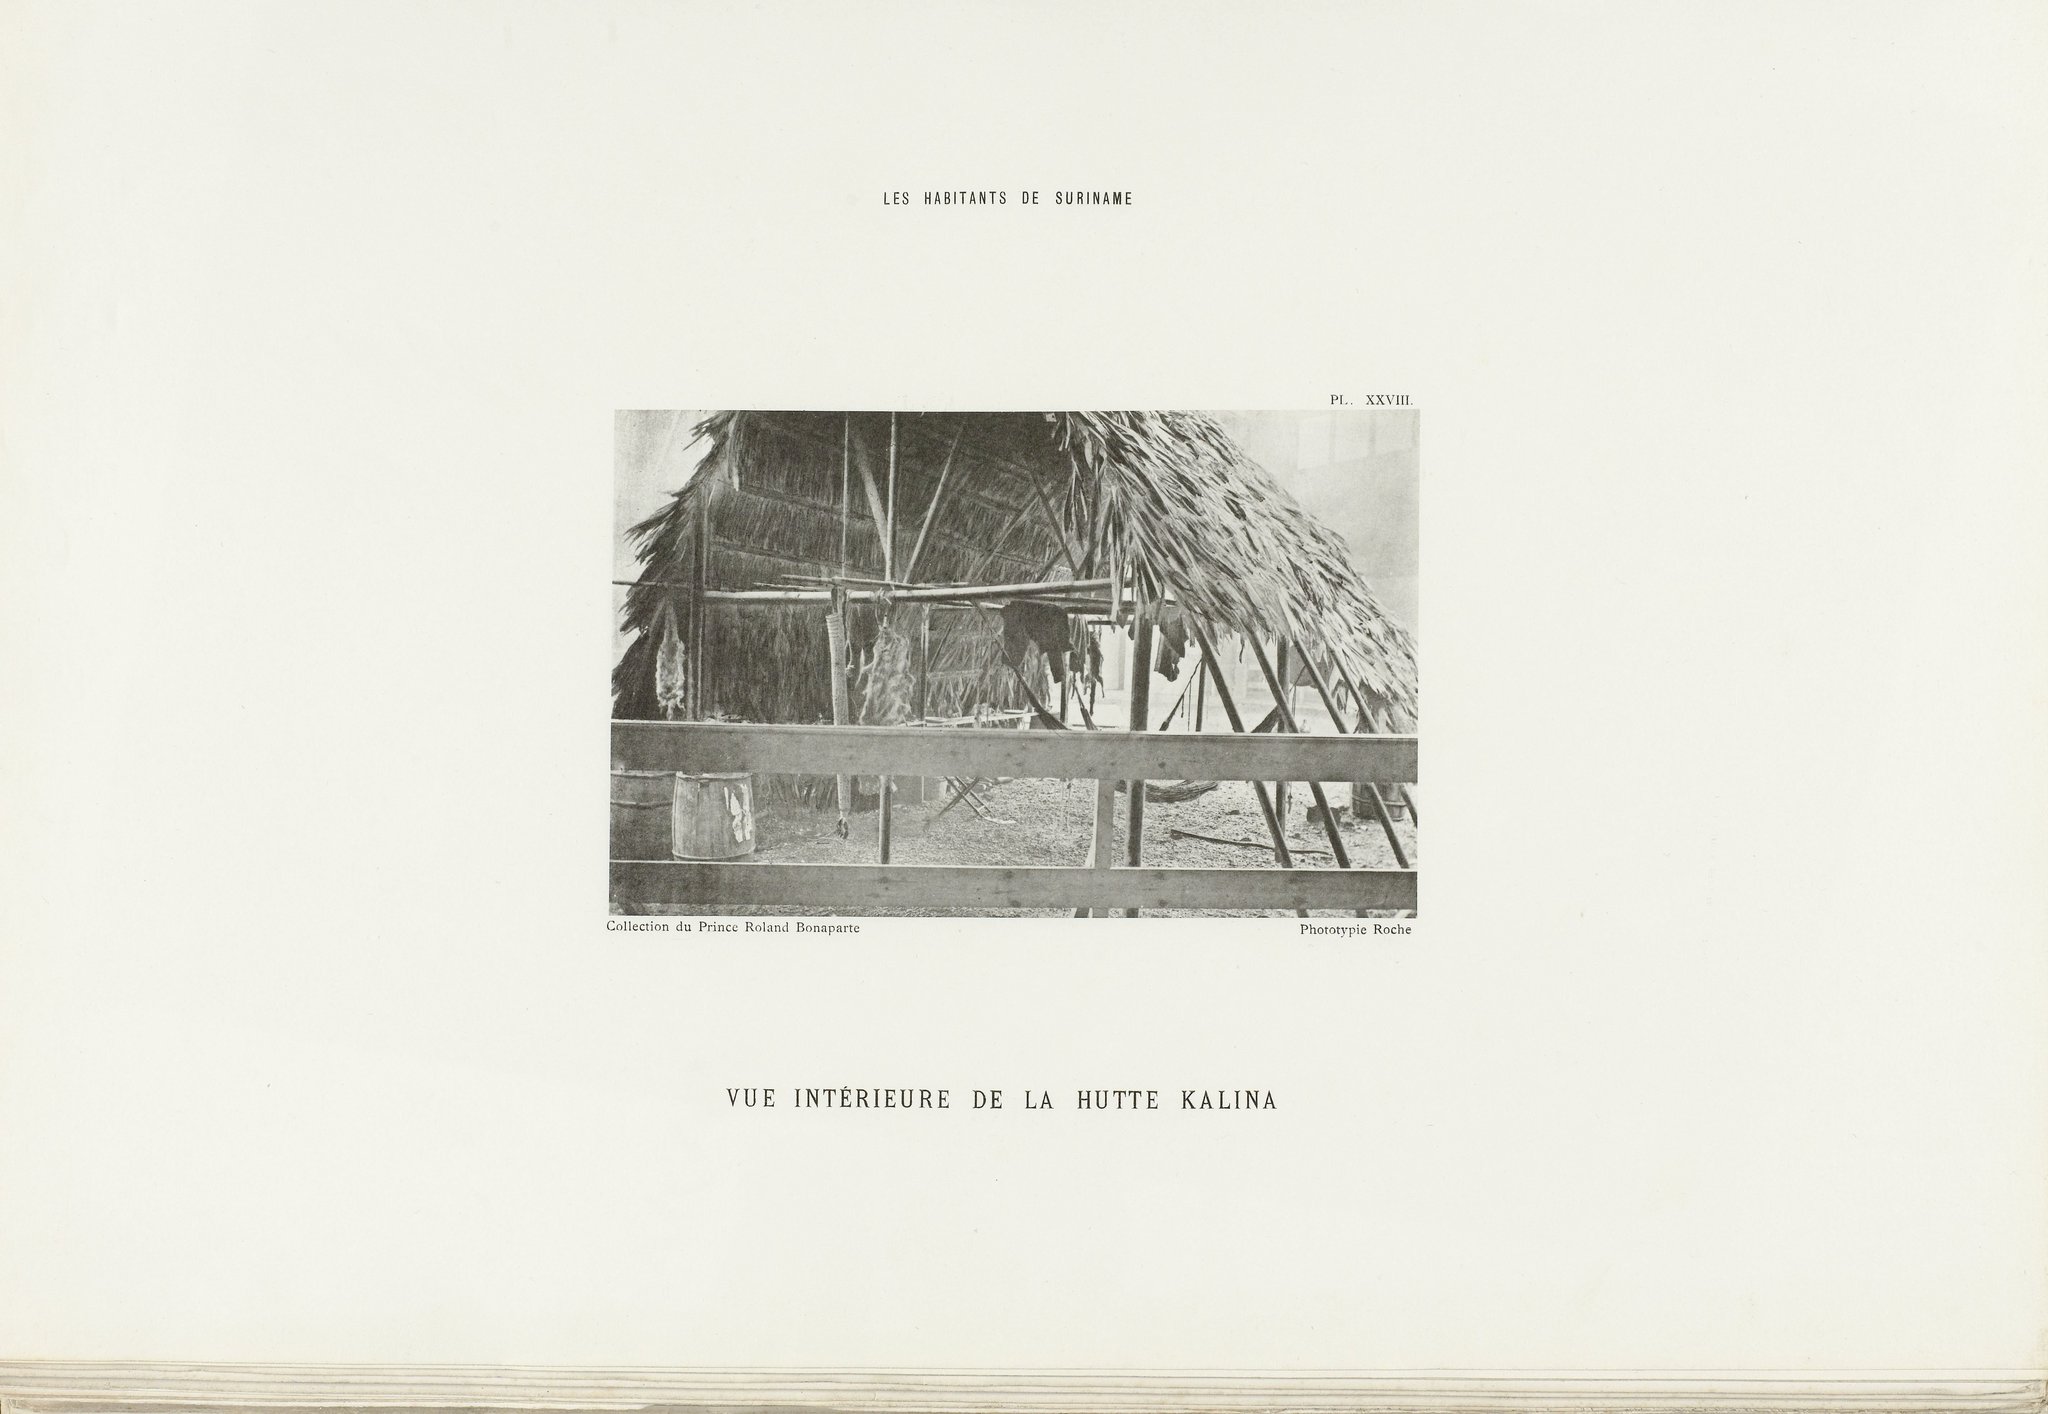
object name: page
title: Interieur van een hut op de Koloniale tentoonstelling, Amsterdam 1883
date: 1883-1884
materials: paper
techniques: photograph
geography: amsterdam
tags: world fair, world exhibition, hut, cabin, lodge, amsterdam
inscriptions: inscription: ‘Collection du Prince Roland Bonaparte/ Phototypie Roche’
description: Interieur van een Caraïebse woning uit Suriname, gefotografeerd op de Internationale Koloniale en Uitvoerhandel Tentoonstelling, Amsterdam 1883.